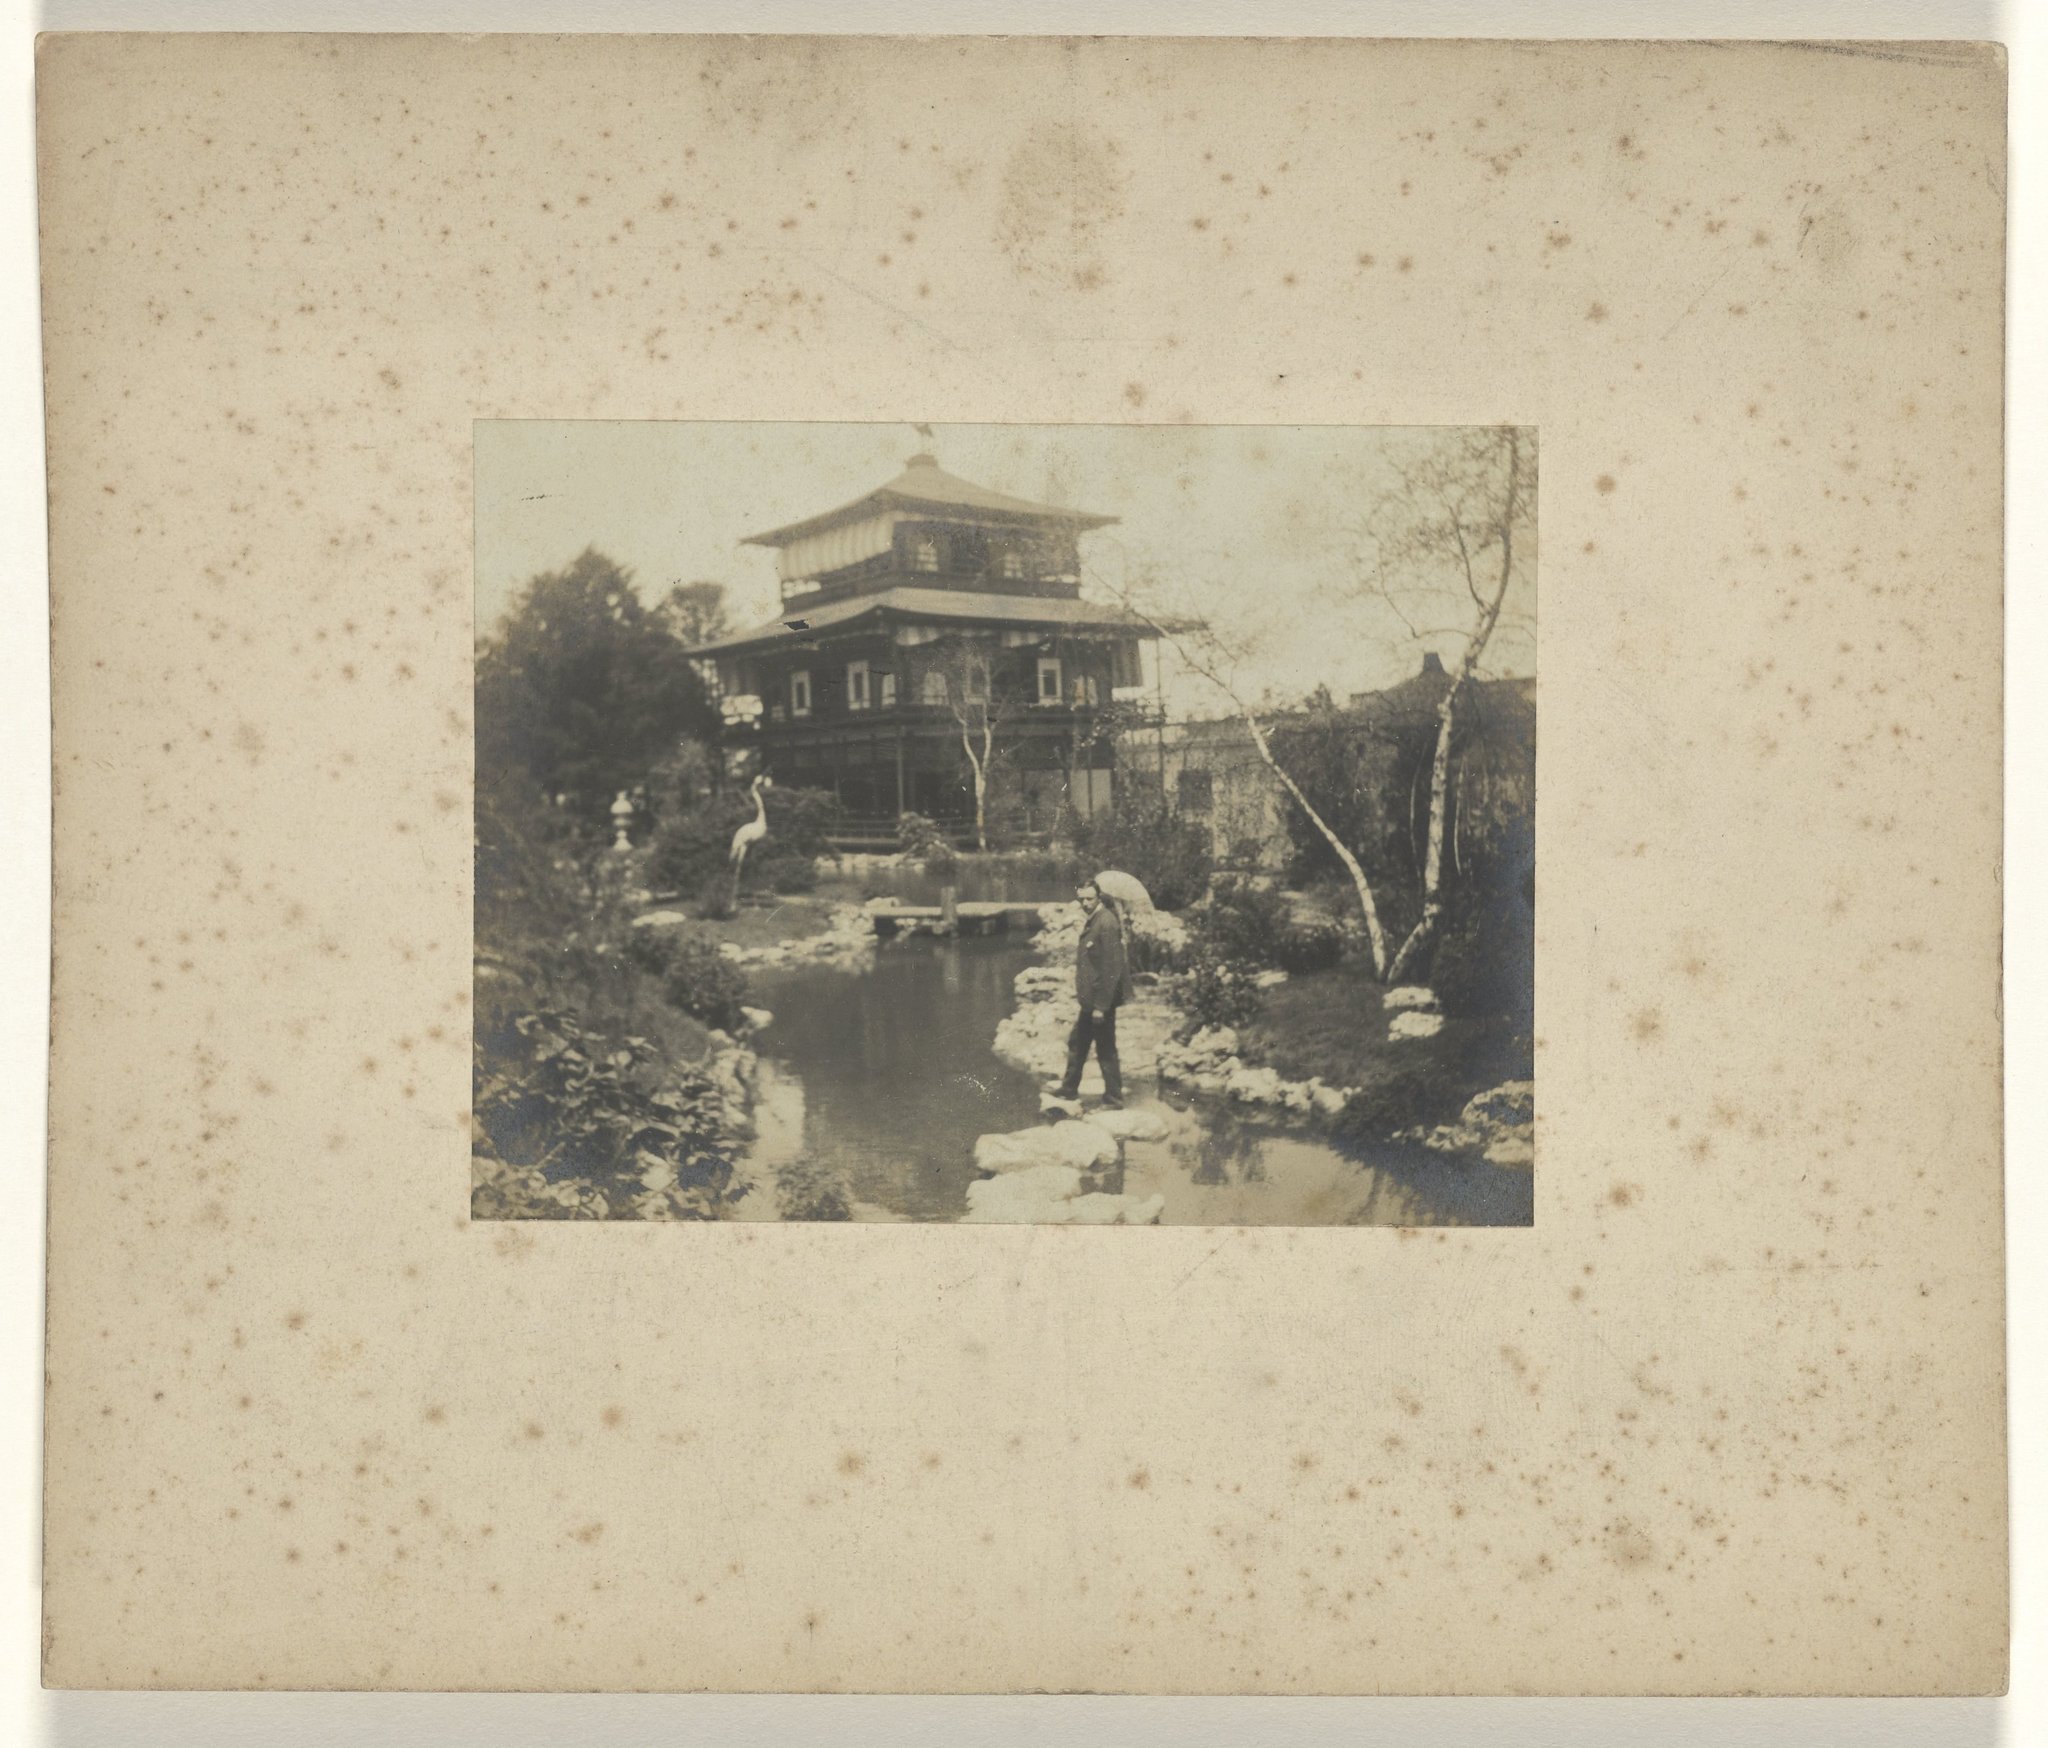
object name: photograph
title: Jan C. Schüller in de tuin bij het Japanse theehuis (‘Japan Tea Palace’) op de wereldtentoonstelling in St. Louis (Louisiana Purchase Exposition), 1904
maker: Anonymous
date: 1904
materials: cardboard, paper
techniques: gelatin silver print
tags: painter, print maker, draughtsman, jan schüller, world fair, world exhibition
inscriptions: annotation: ‘In Japan // ’t mooiste plekje van de Fair’, annotation: ‘Jan C. Schüller’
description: Jan C. Schüller in de tuin bij het Japanse theehuis (‘Japan Tea Palace’) op de wereldtentoonstelling in St. Louis (Louisiana Purchase Exposition), 1904.